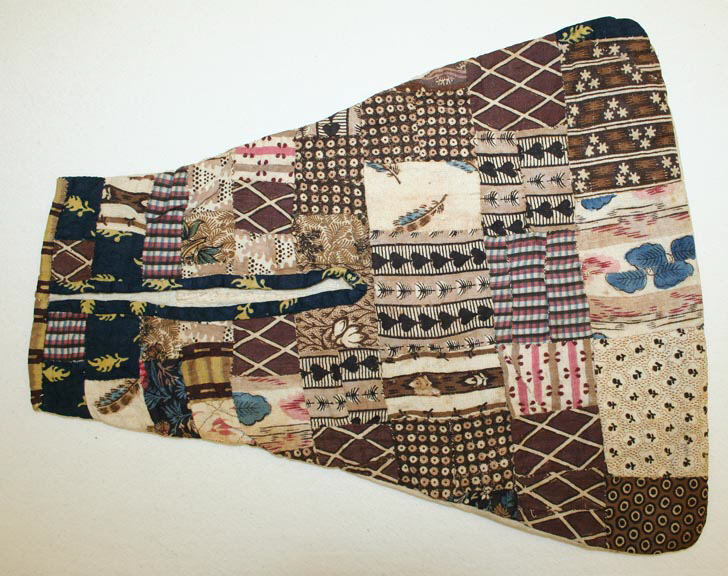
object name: pocket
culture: american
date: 1801-1833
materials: cotton